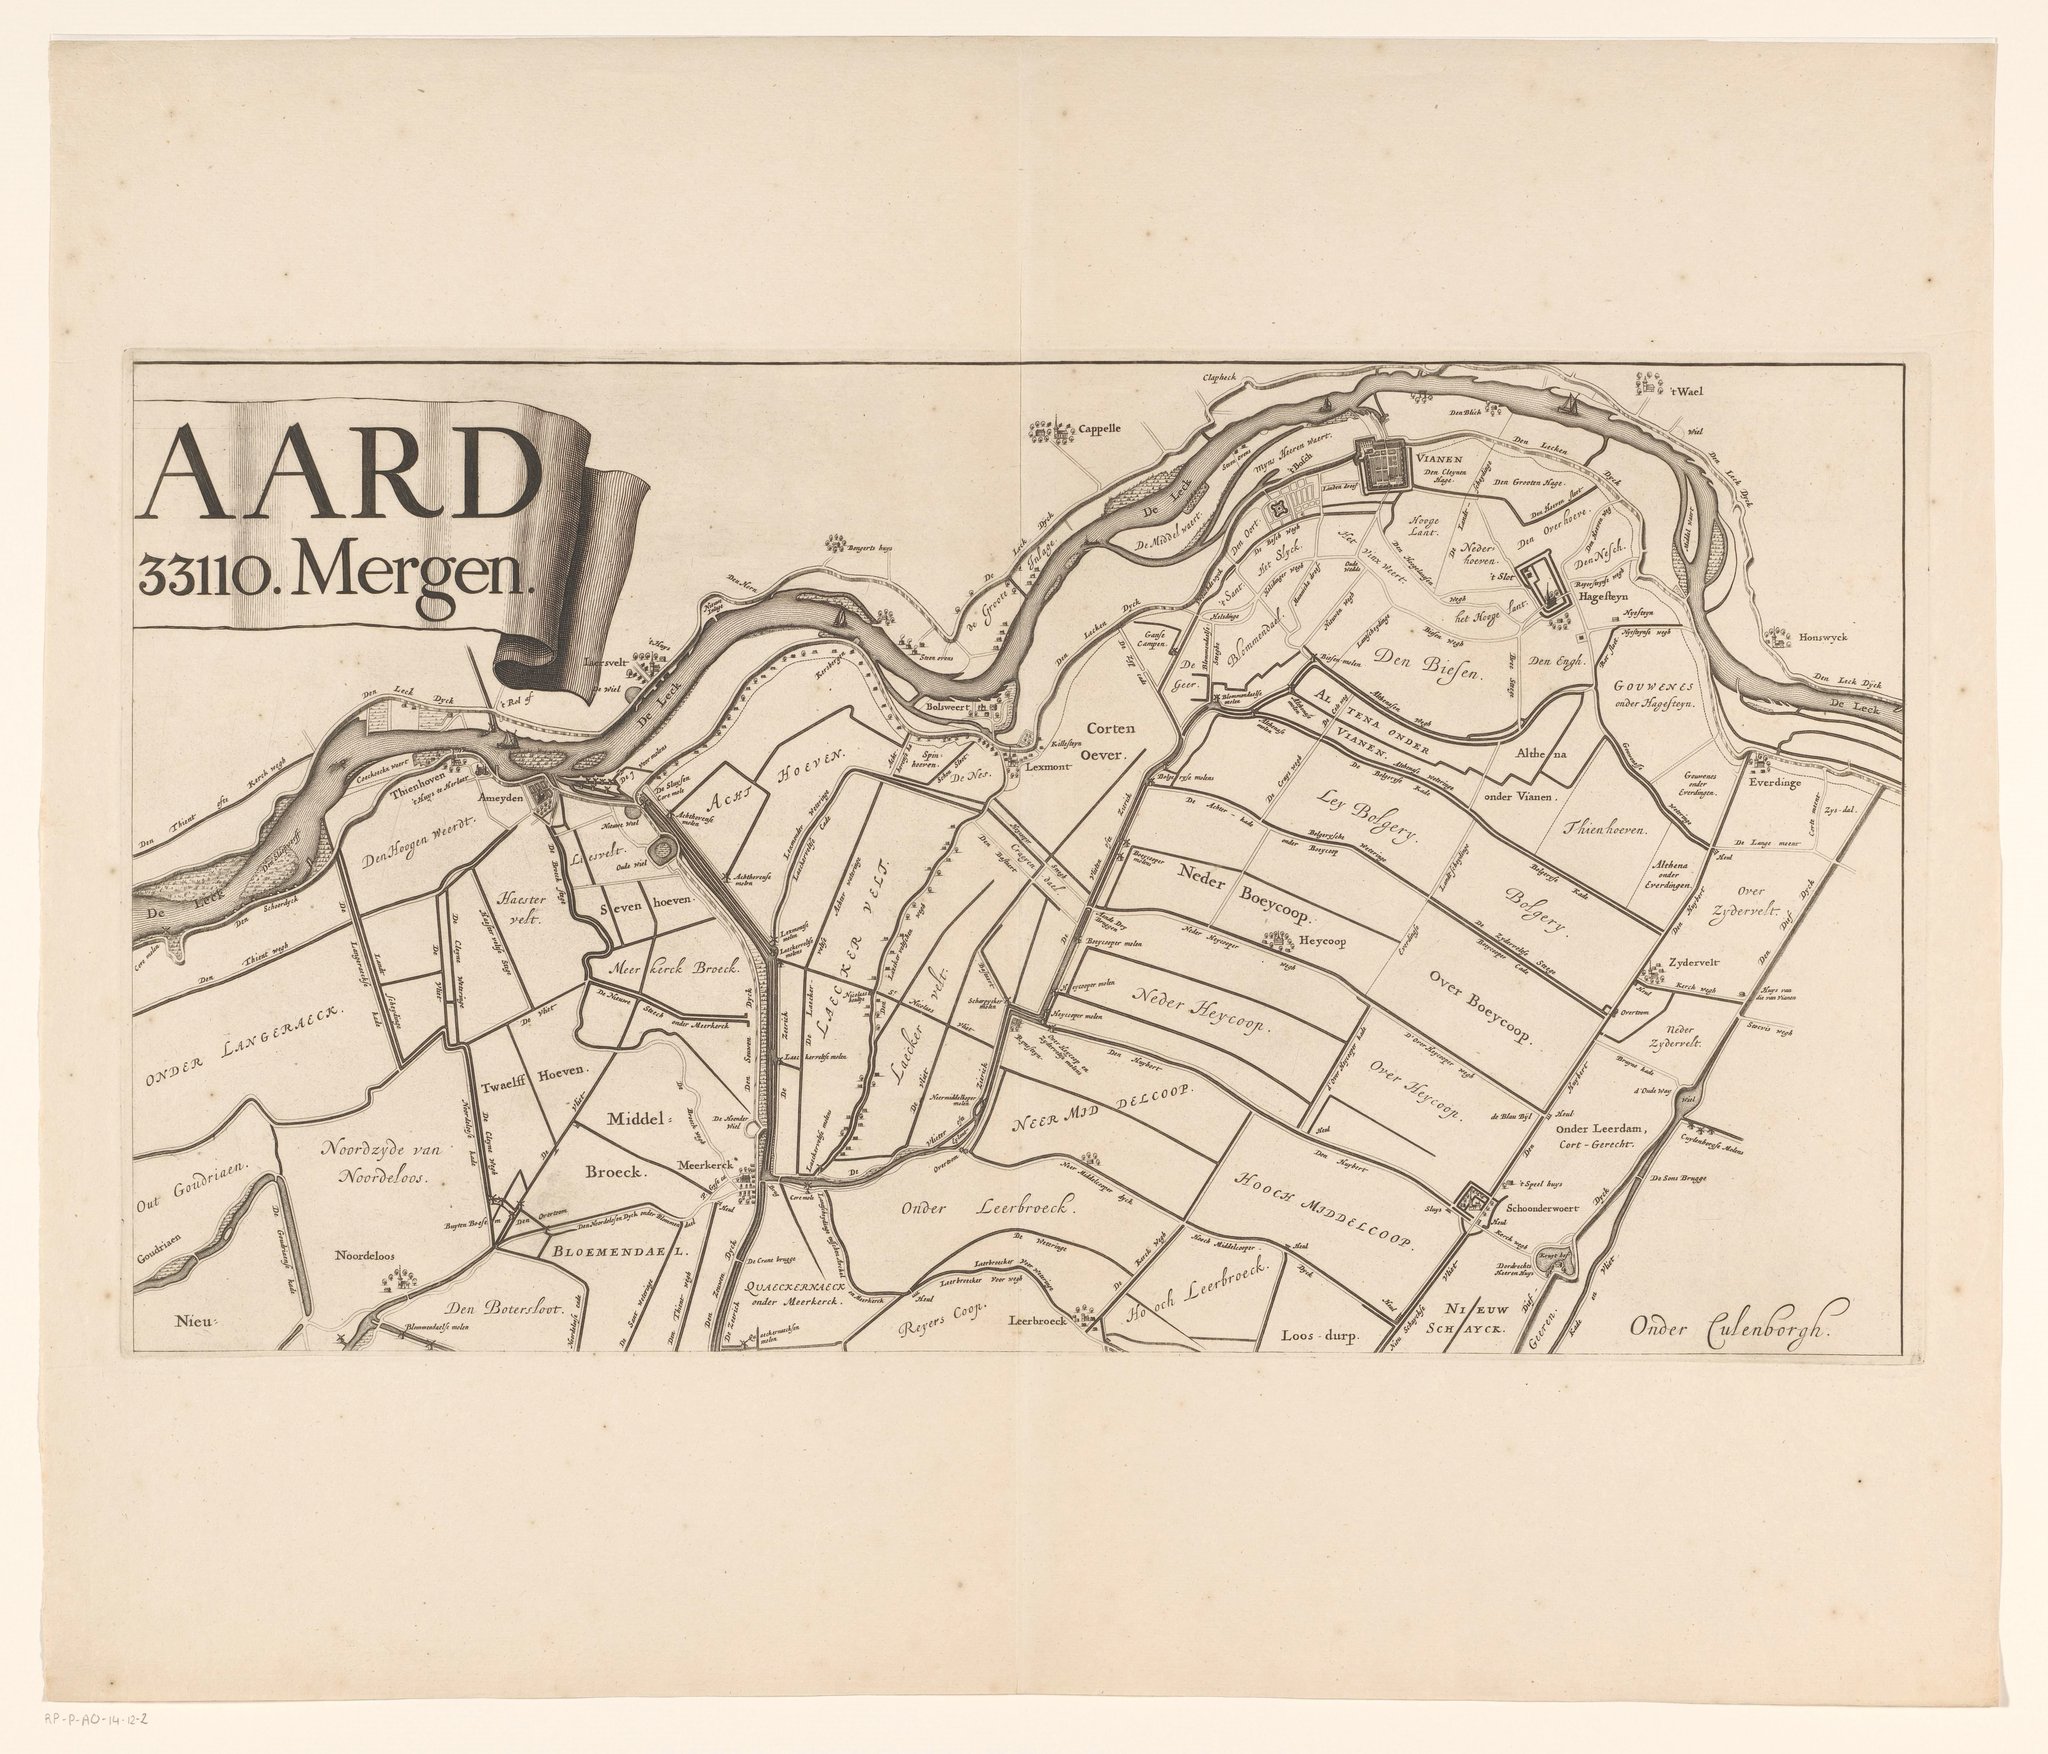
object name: print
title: Kaart van de Alblasserwaard en de Vijfheerenlanden (deel rechtsboven)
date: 1681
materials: paper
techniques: engraving, etching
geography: amsterdam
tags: maps of separate countries or regions, polder, reclaimed land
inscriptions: collector's mark: Lugt 195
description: Deel (rechtsboven) van een kaart van de Alblasserwaard en de Vijfheerenlanden, bestaande uit vier delen en een wapenrand.